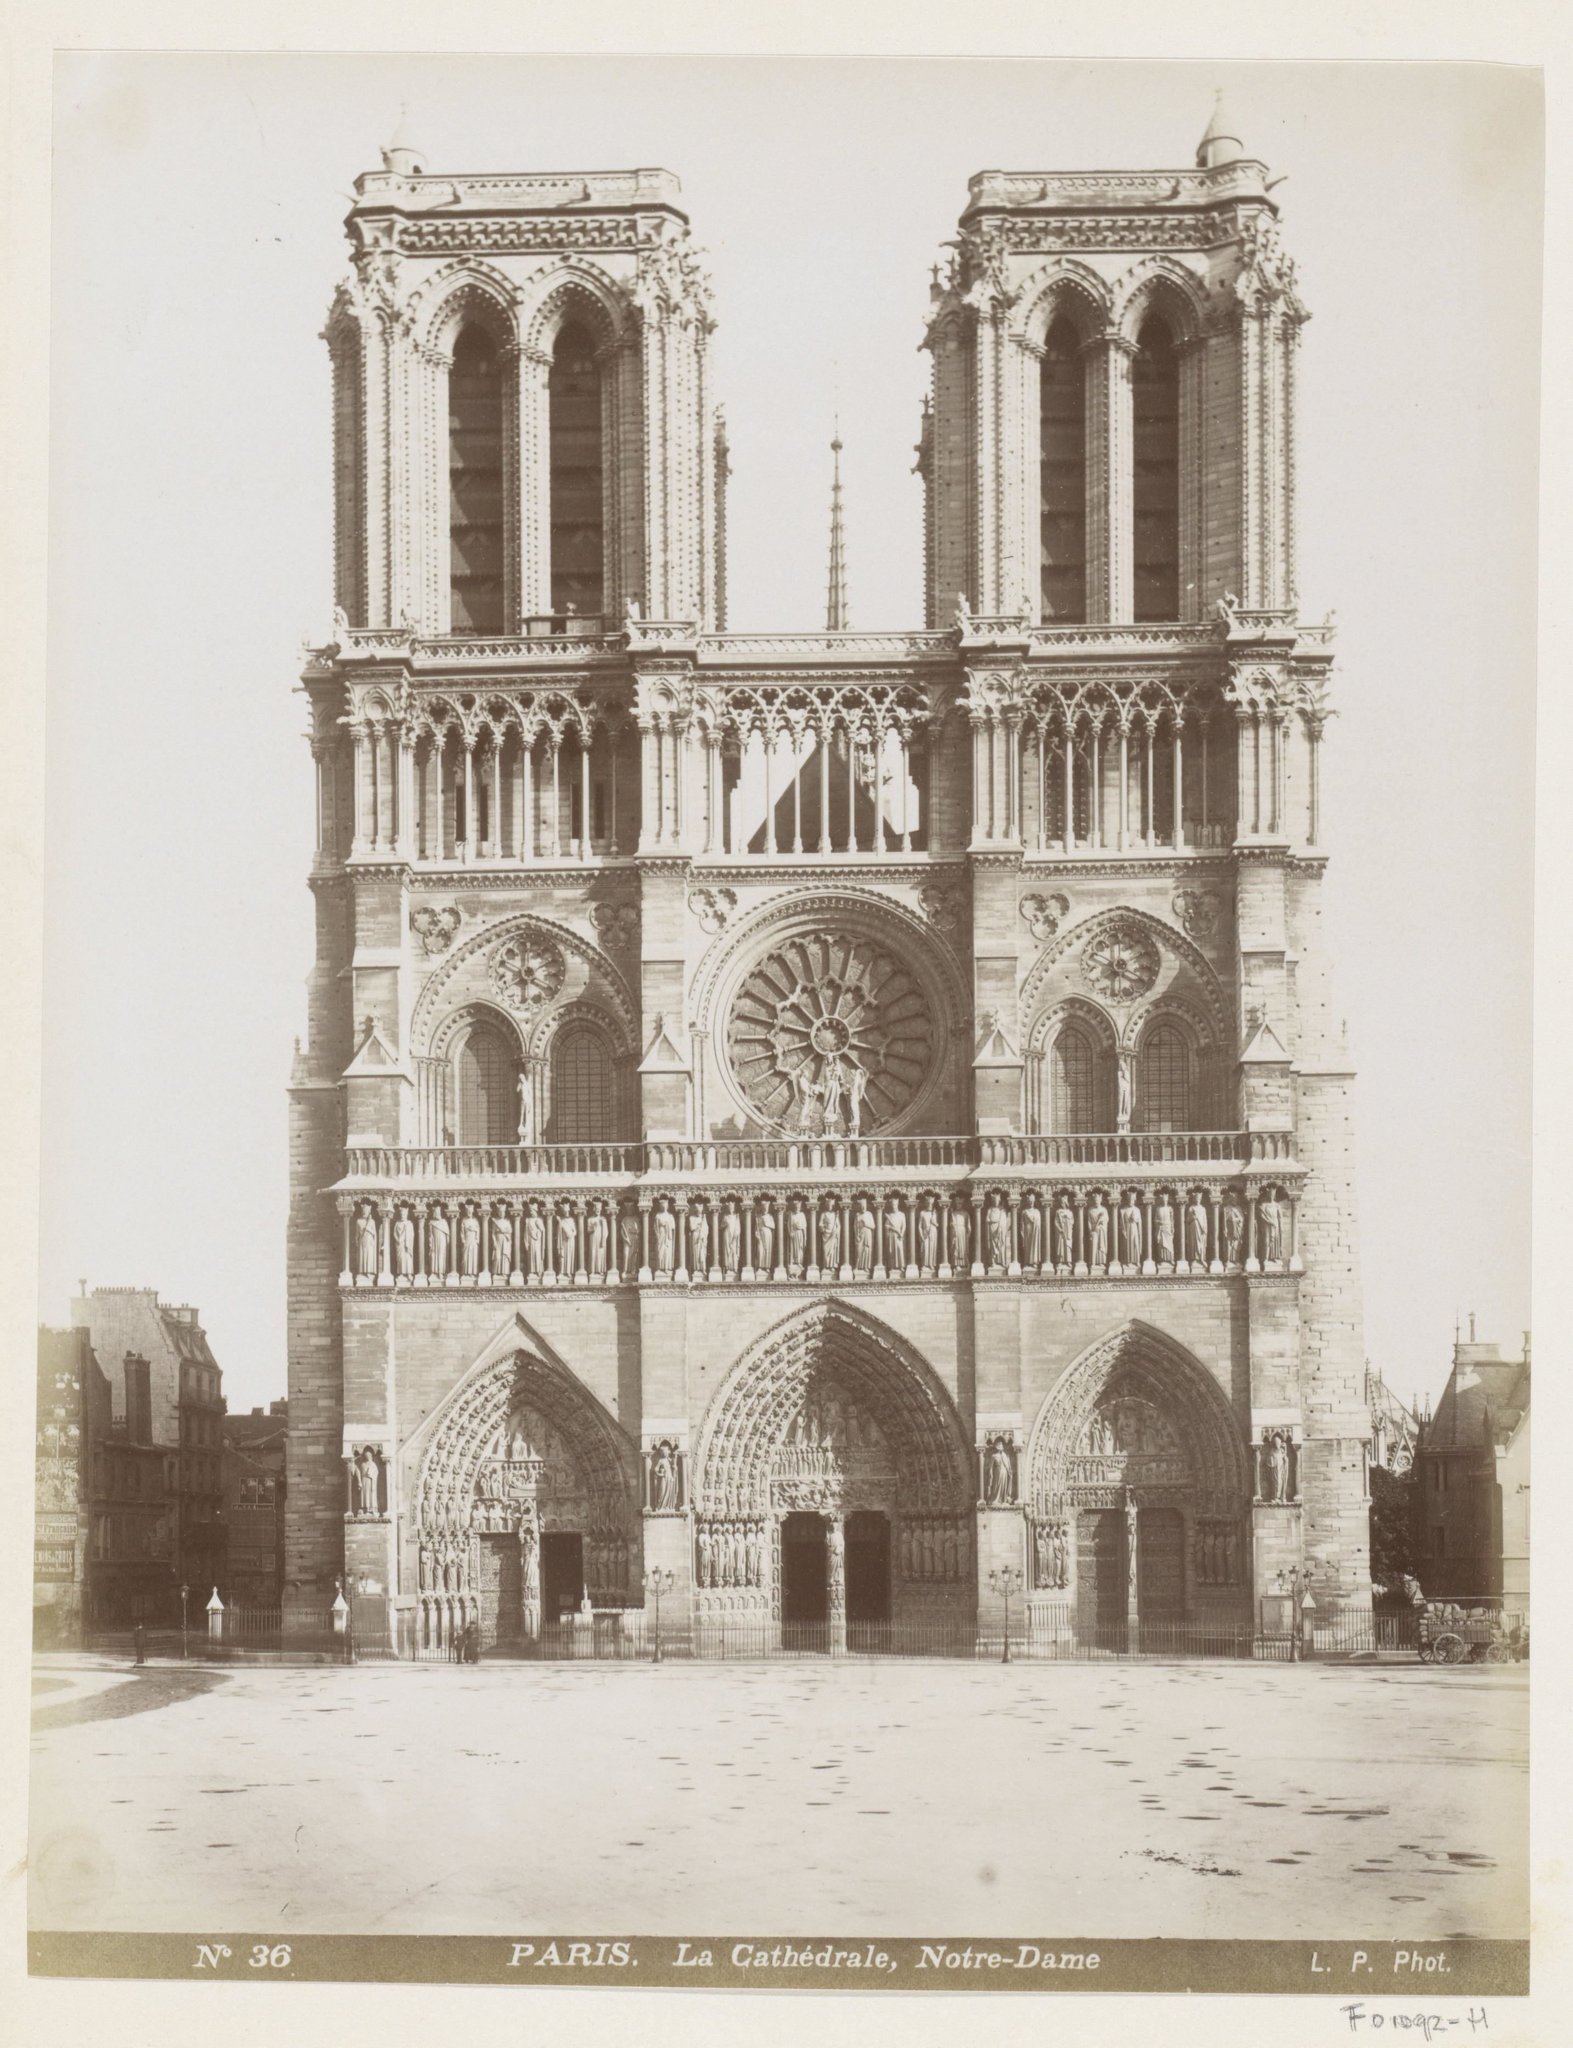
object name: photograph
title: Exterieur van de Cathédrale Notre-Dame in Parijs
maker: louis antoine pamard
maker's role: fotograaf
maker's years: 1840-1893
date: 1880-1900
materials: cardboard, paper, photographic support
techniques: albumen print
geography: paris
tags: church (exterior), parts of church exterior and annexes: tower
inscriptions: negative number: ‘36’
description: Onderdeel van Reisalbum met foto's van bezienswaardigheden in België en Frankrijk.